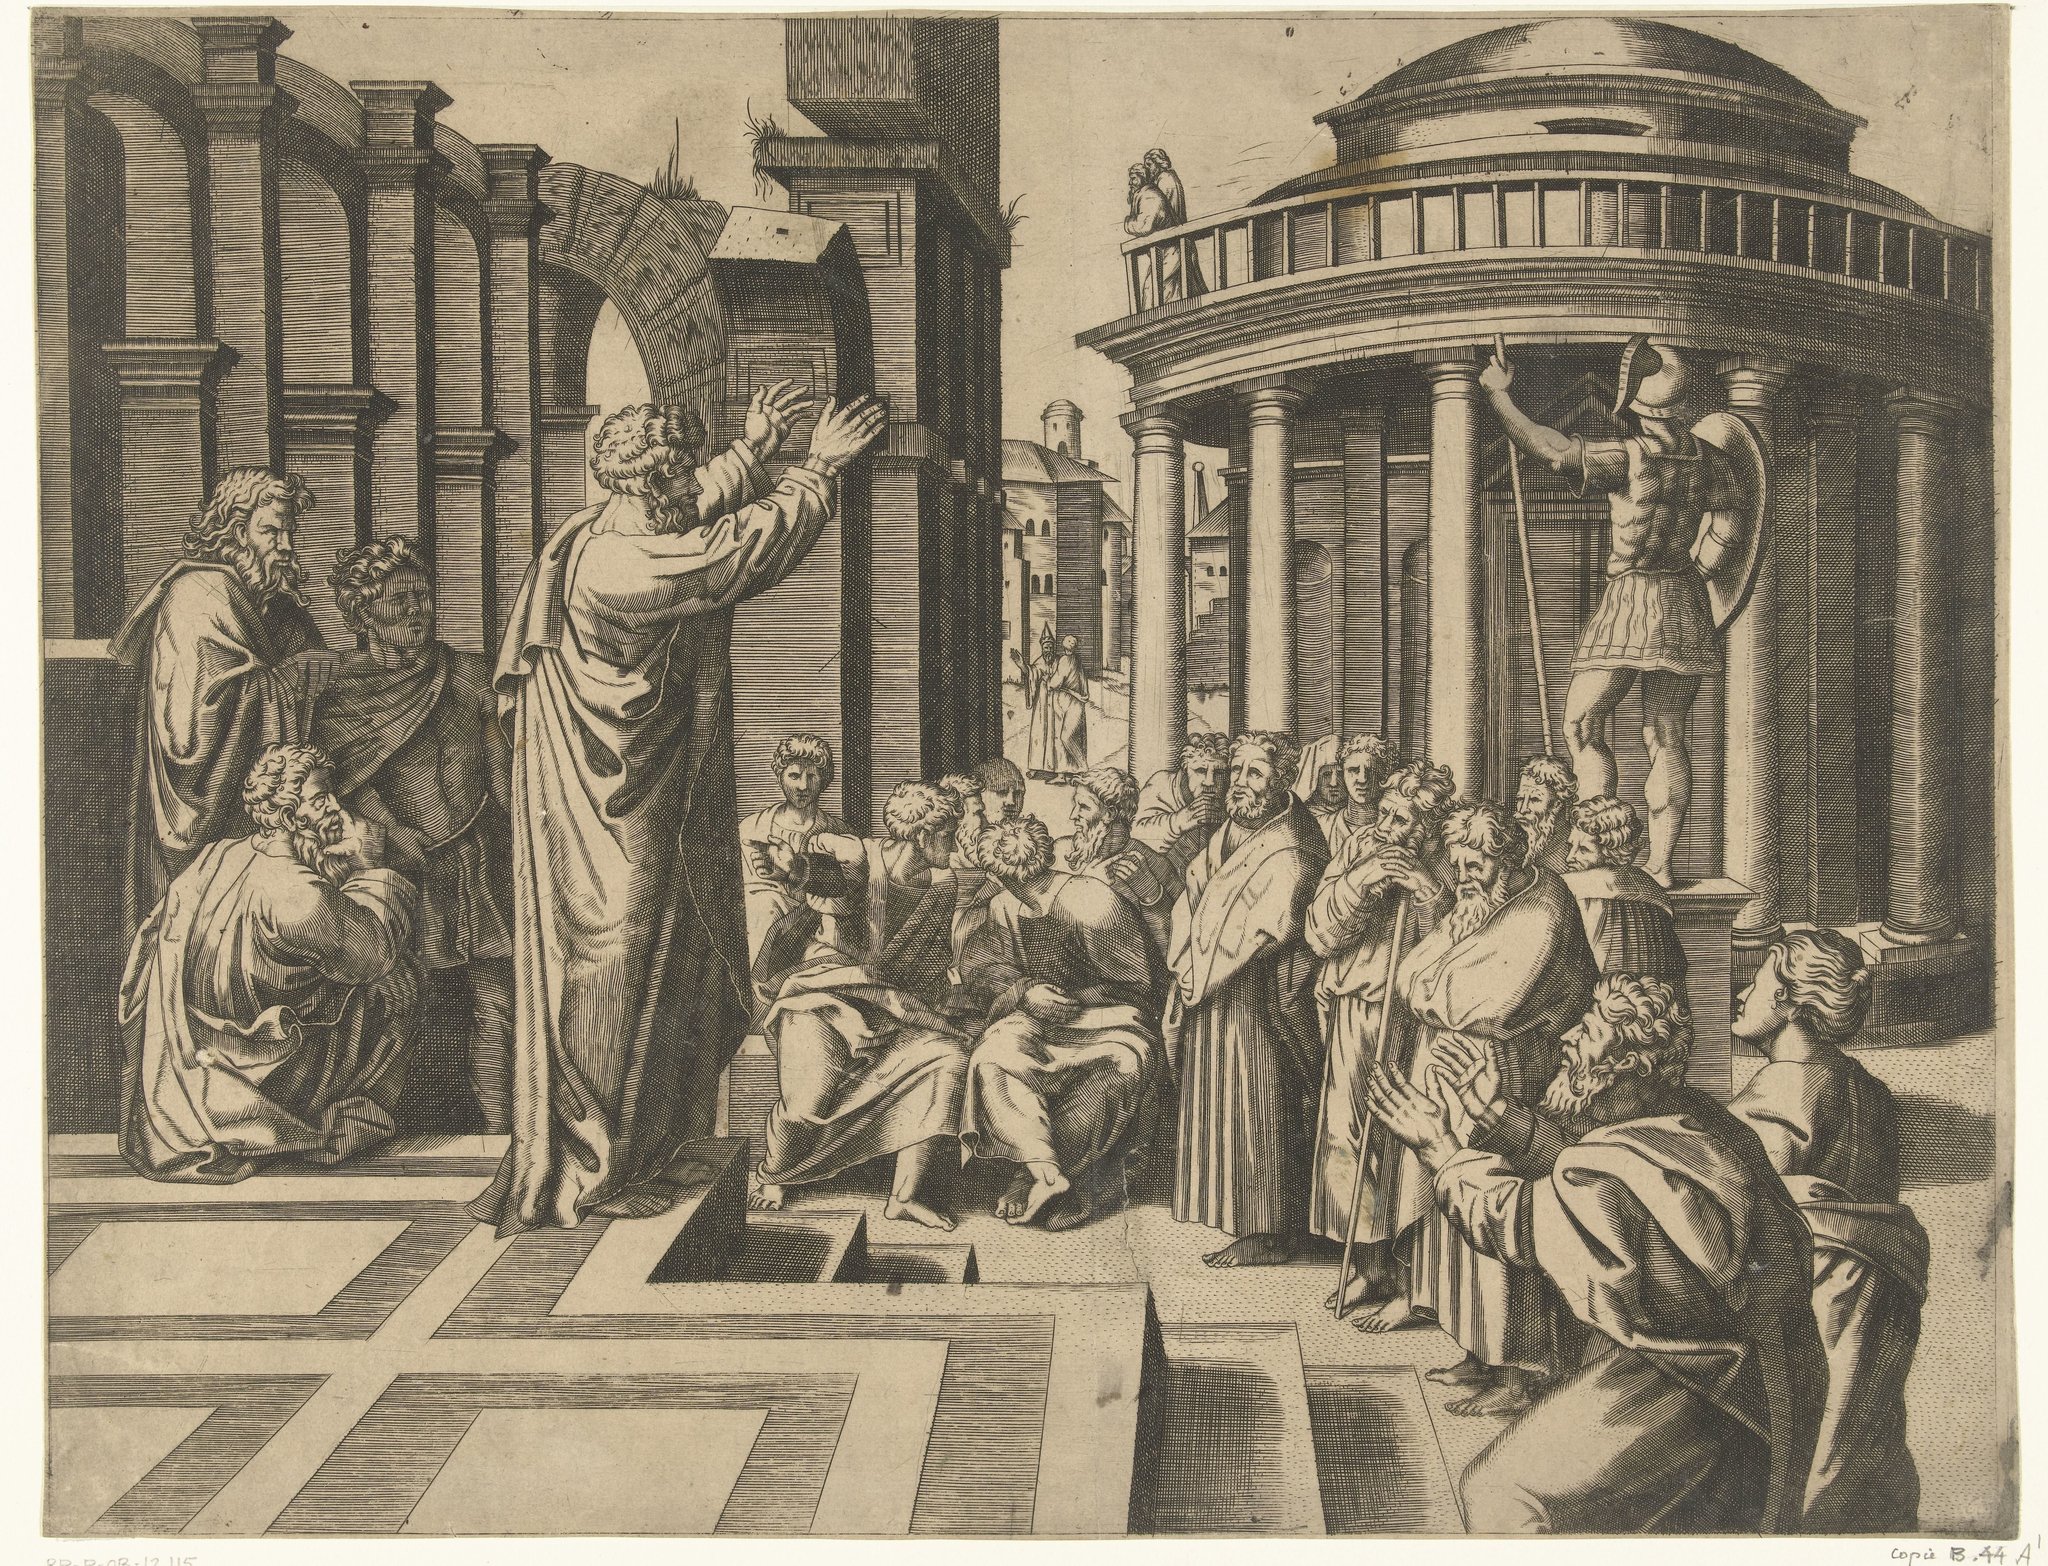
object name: print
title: Prediking van Paulus in Athene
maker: Anonymous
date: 1517-1570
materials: paper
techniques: engraving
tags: paul in athens: on the areopagus he discusses with philosophers (in front of the temple of mars)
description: Kopie naar prent van Marcantonio Raimondi. Raimondi baseerde zich op carton met ontwerp voor een tapijt in de Sixtijnse kapel, Rome van Raphael (Shoemaker 1981, p. 152-154).